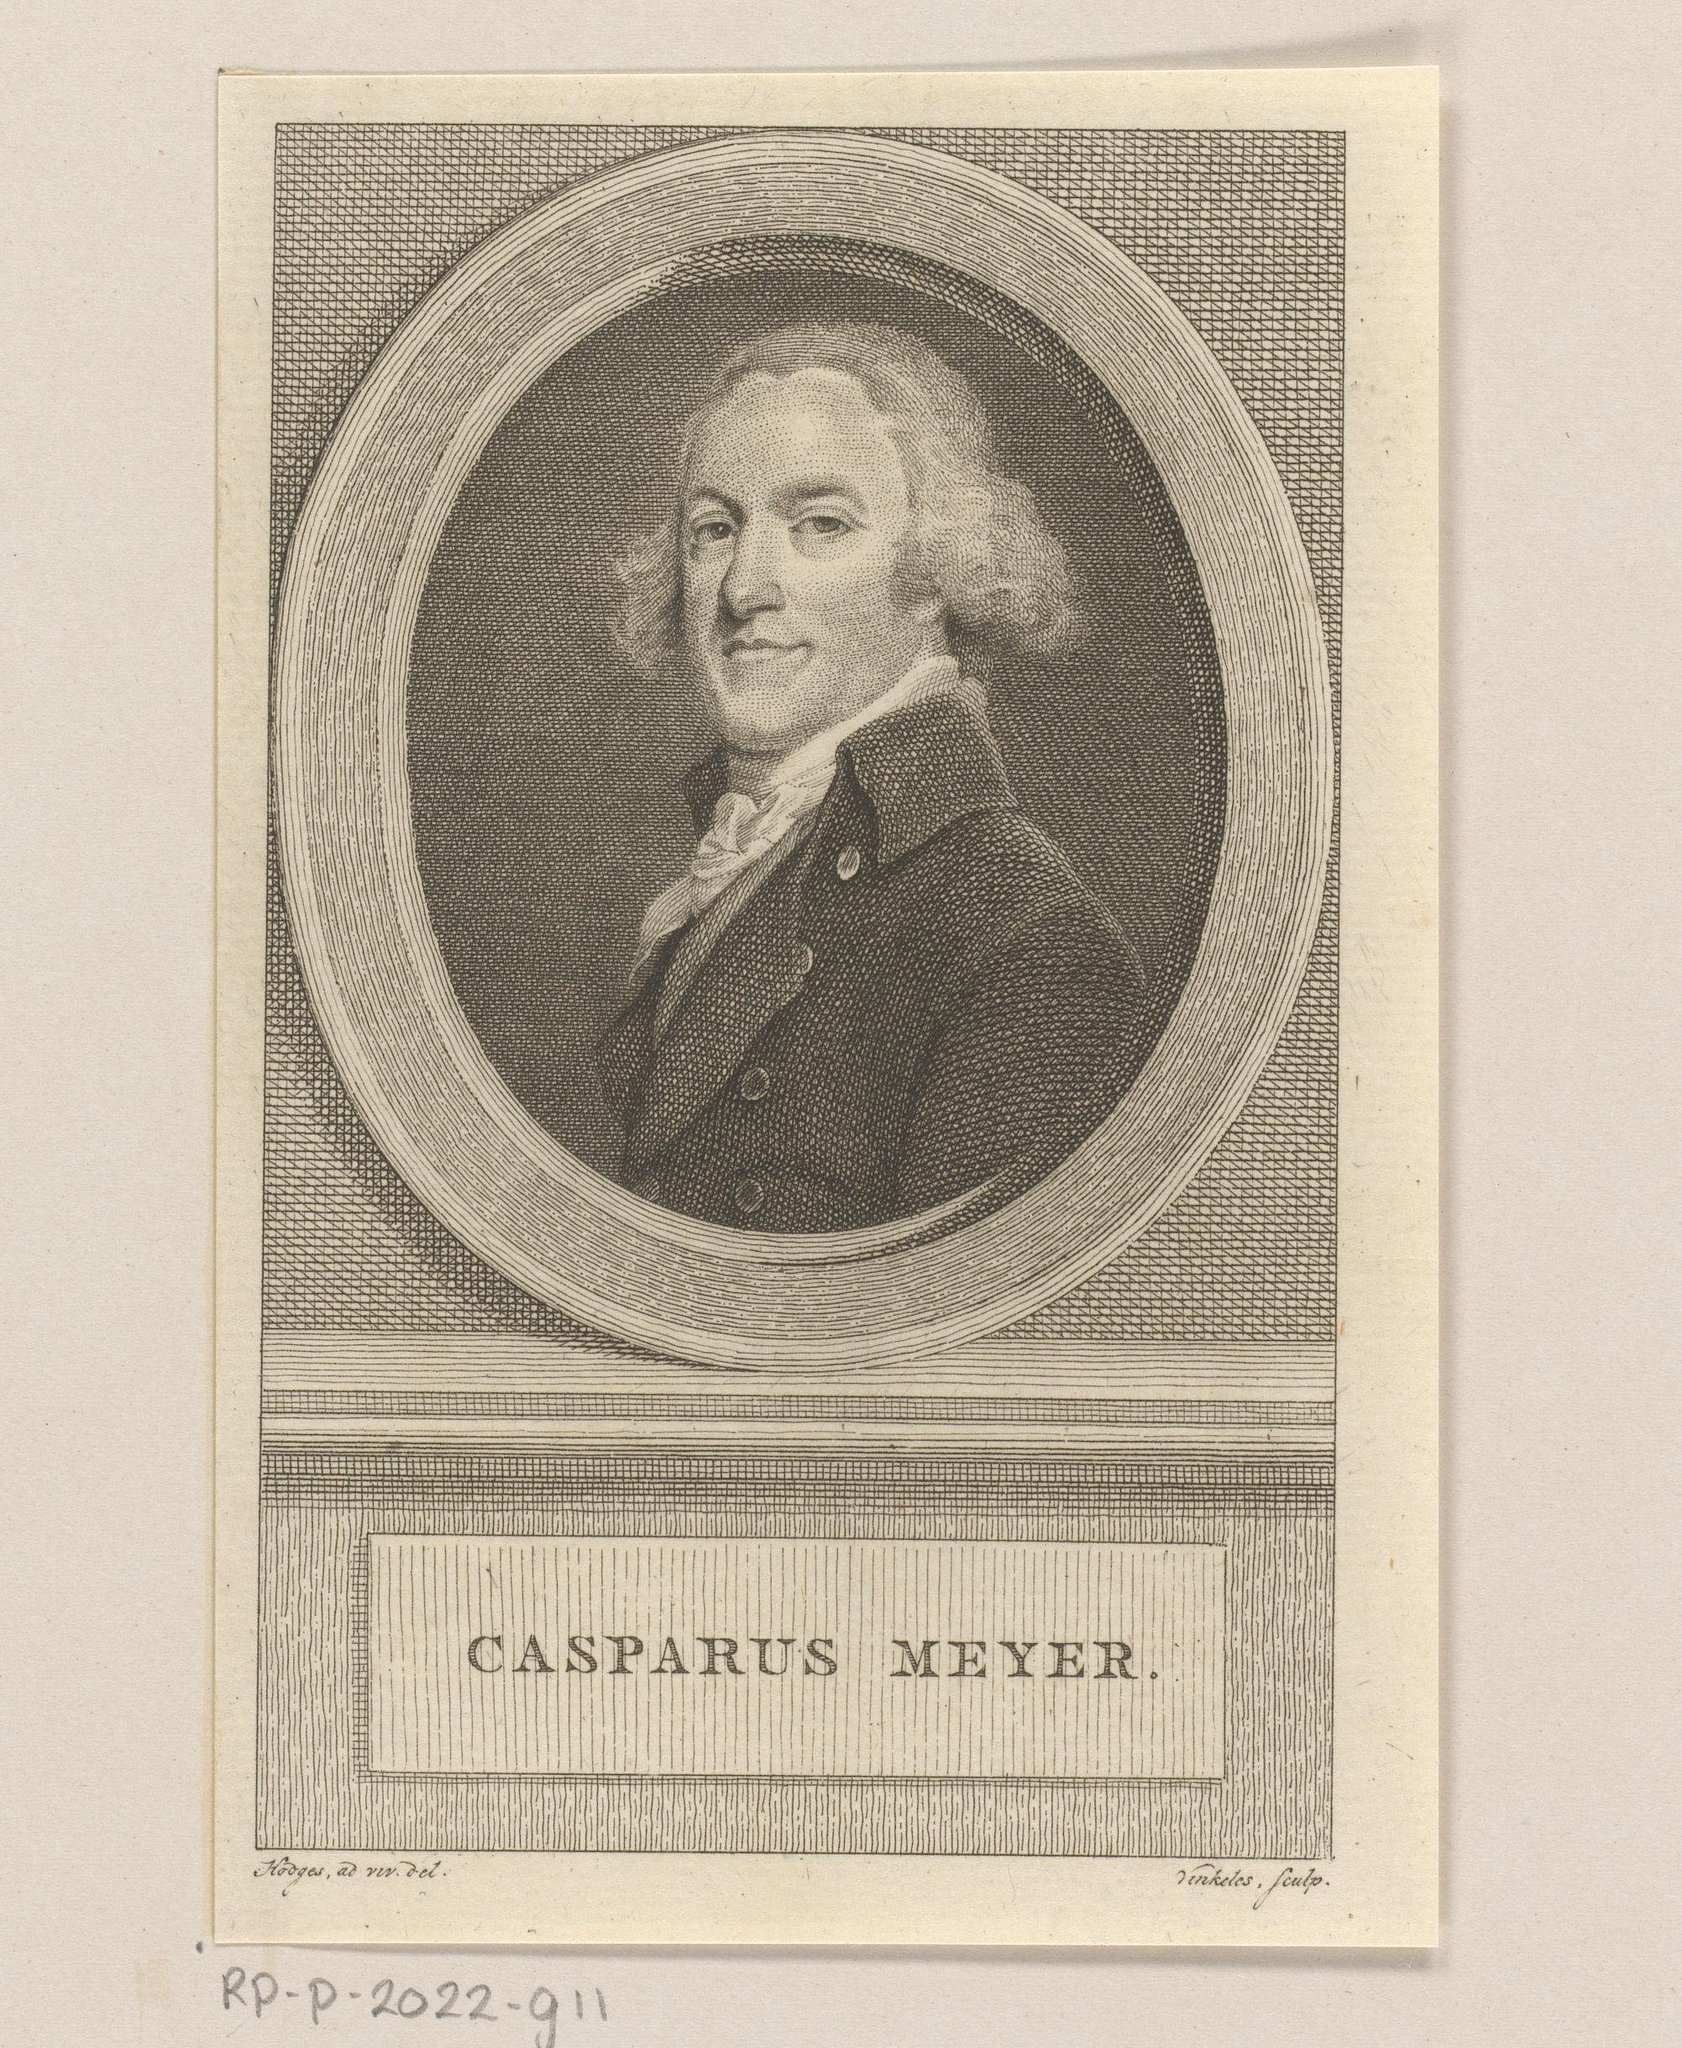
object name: print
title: Portret van Casparus Meijer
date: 1803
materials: paper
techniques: etching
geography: amsterdam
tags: historical persons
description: Prent waarschijnlijk uit: Wagenaar, Jan. Vaderlandsche historie, (...) ten vervolge van Wagenaars Vaderlandsche historie. Amsterdam: Johannes Allart, 1803, dl. 31.